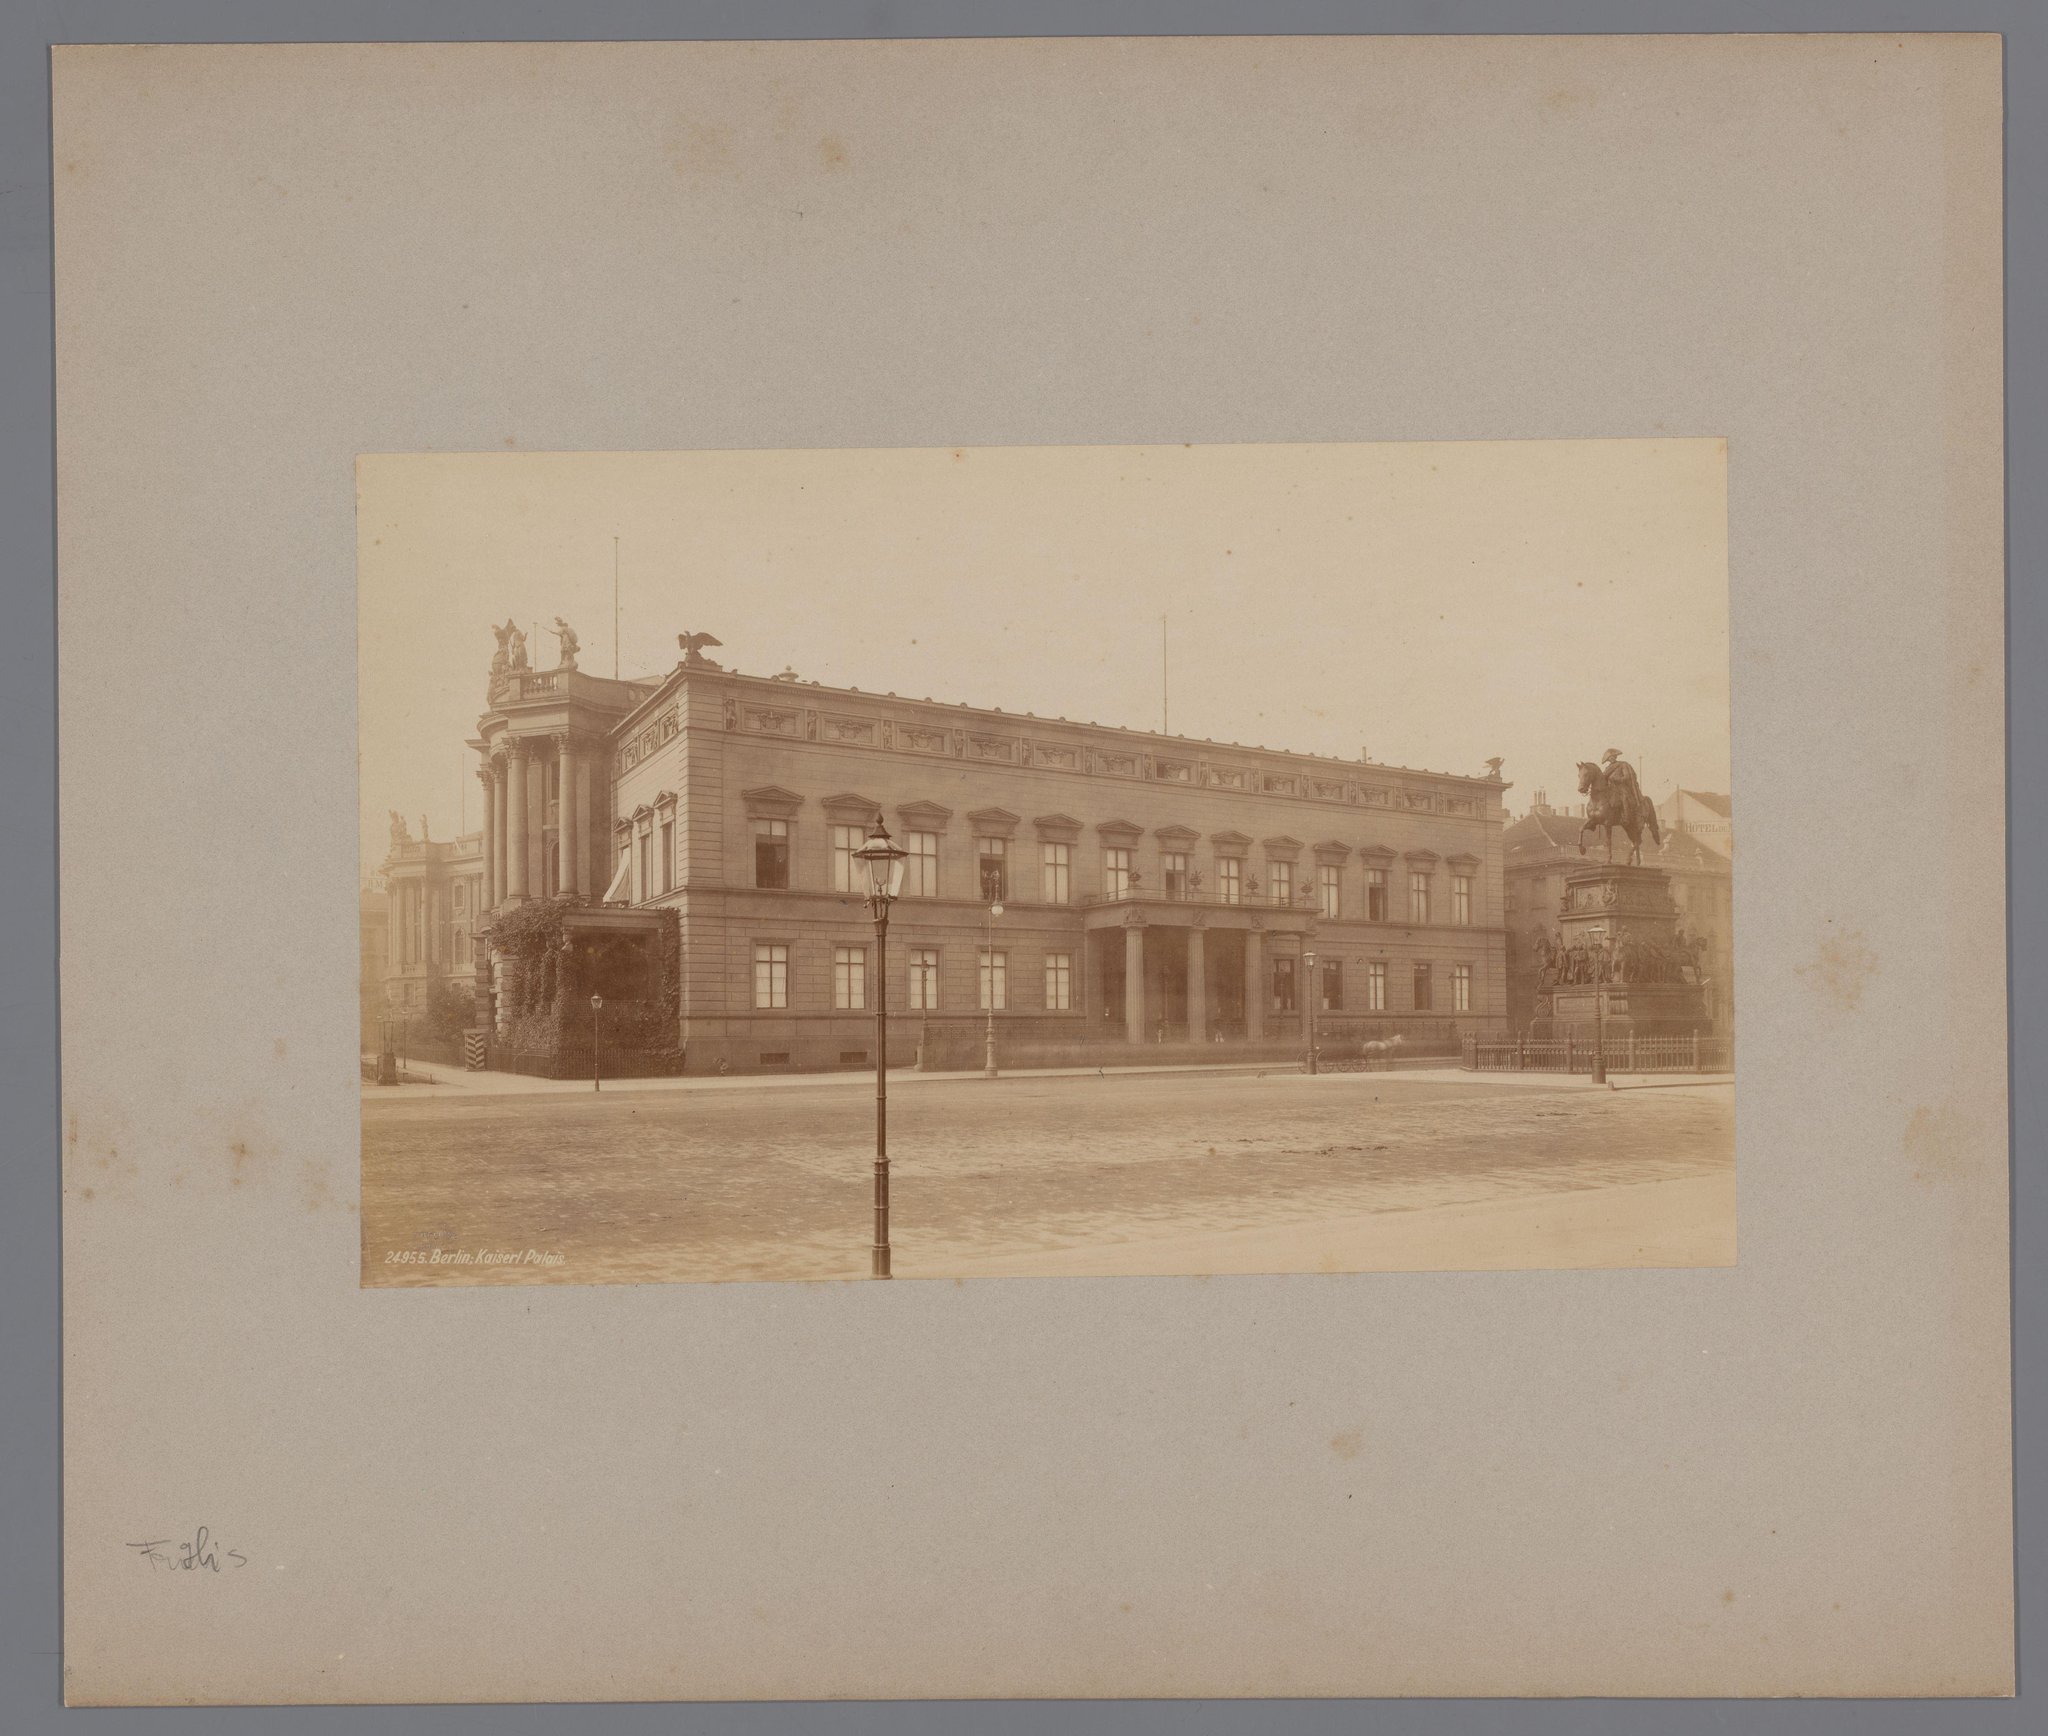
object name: photograph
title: Kaiserlicher Palast, Berlijn, Duitsland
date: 1875-1900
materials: cardboard, photographic support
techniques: albumen print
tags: berlin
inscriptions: inscription: ‘Frith's’, inscription: ‘24955. Berlin; Kaiserl Palais.’, check stamp: ‘Frith's [...]’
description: Kaiserlicher Palast, Berlijn, Duitsland.